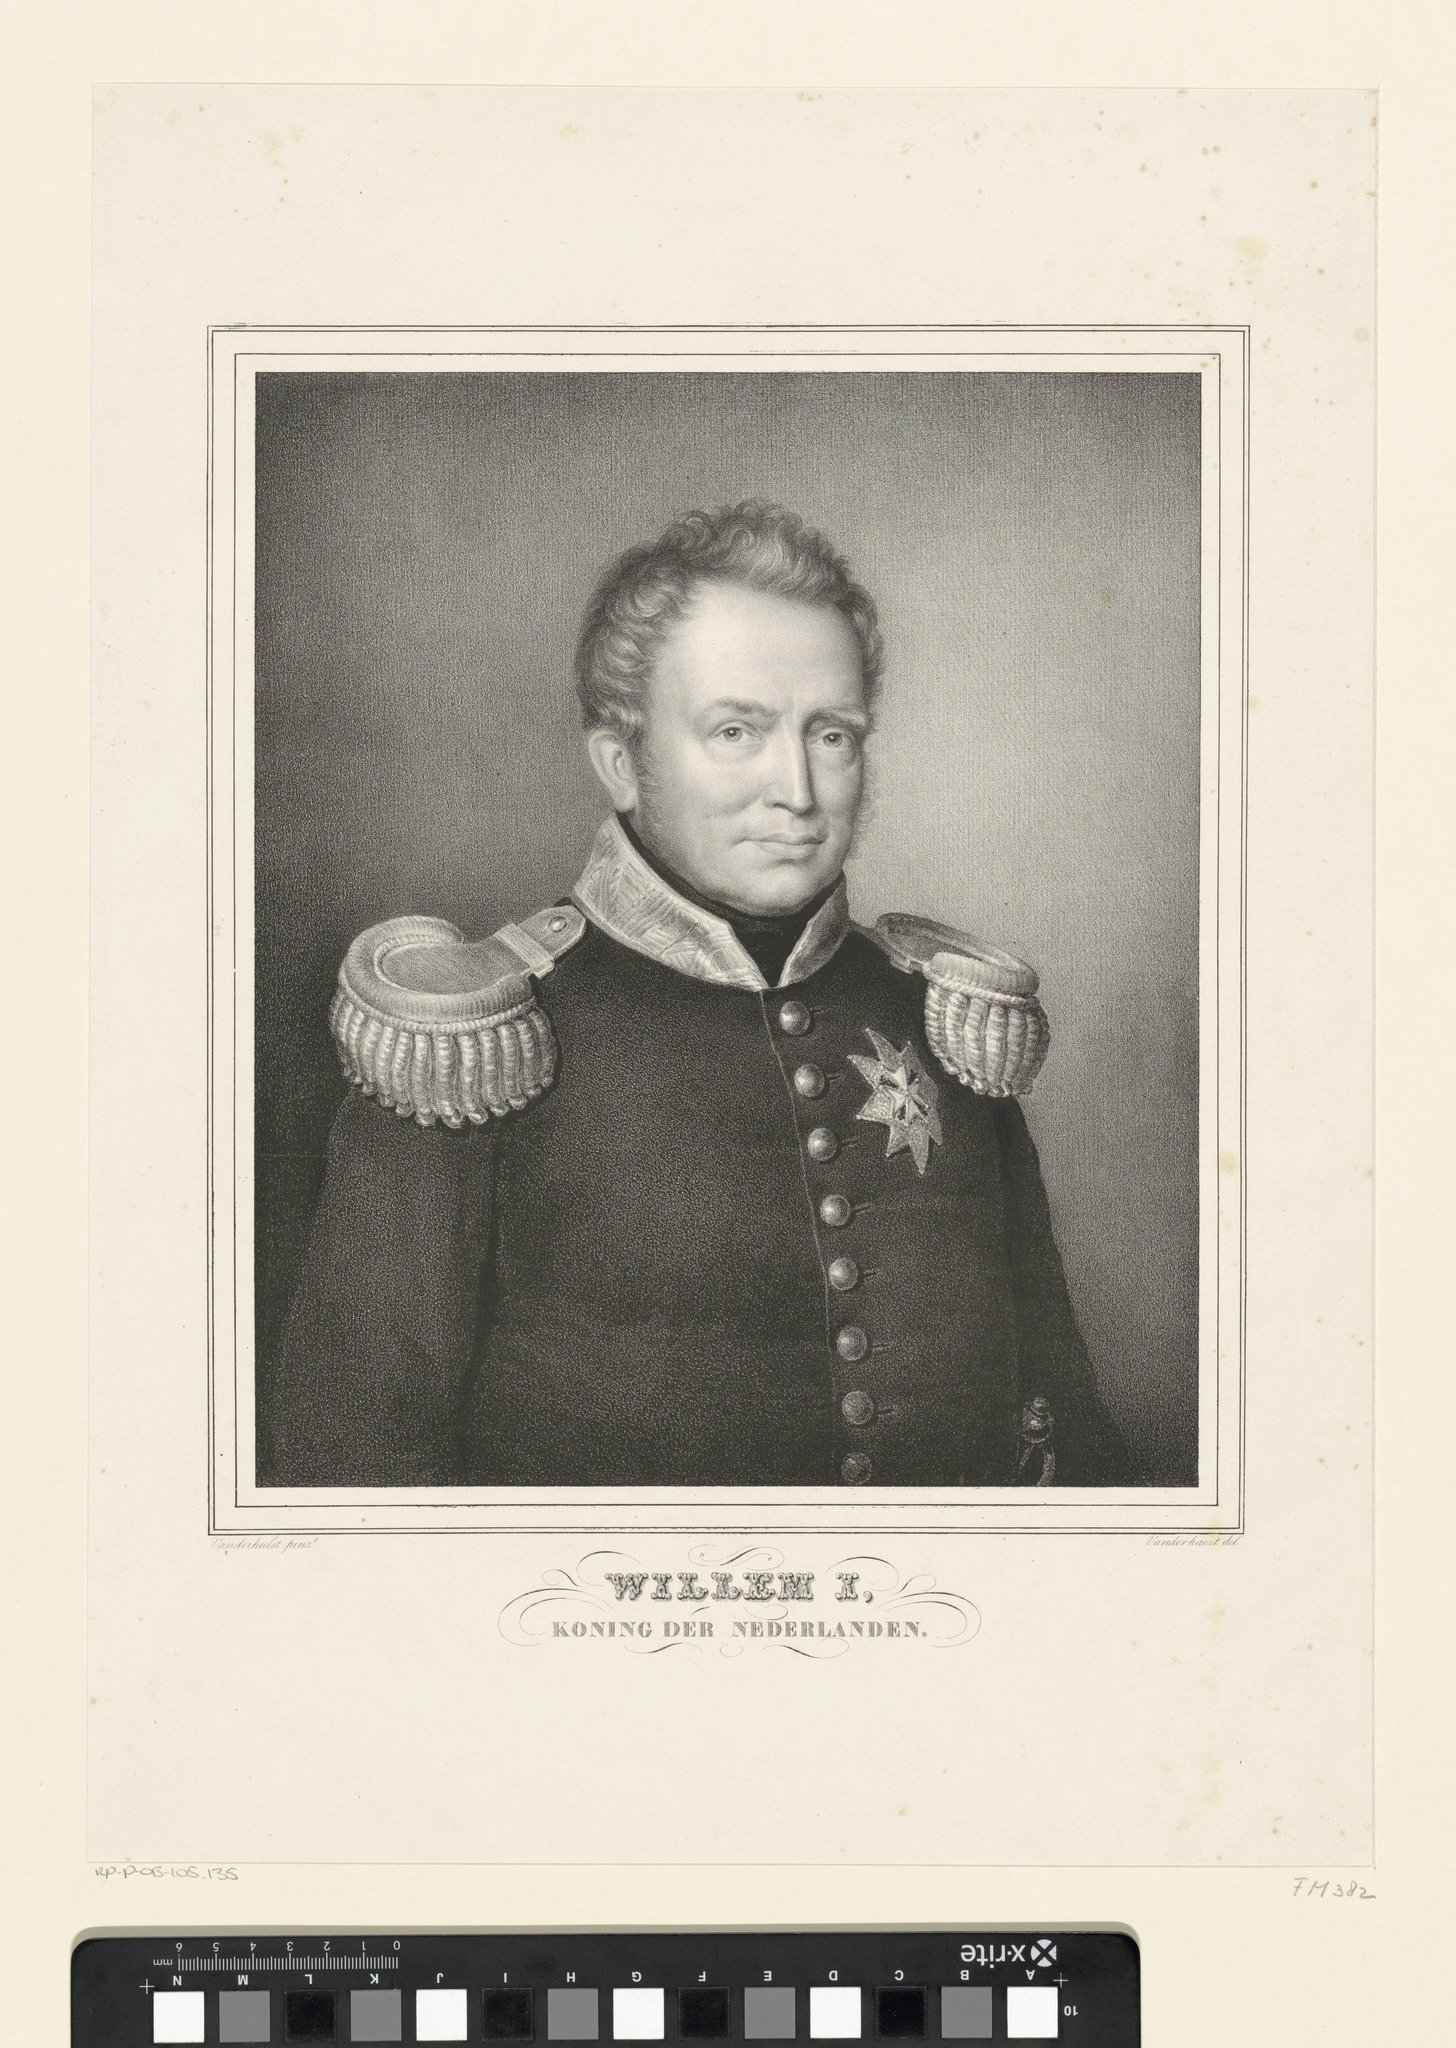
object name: print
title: Portret van Willem I Frederik, koning der Nederlanden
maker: jean-baptiste van der hulst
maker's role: draughtsman, painter, print maker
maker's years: 1790-1862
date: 1831-1832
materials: paper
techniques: lithograph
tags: the hague, berlin, william i of the netherlands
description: De hier vermelde titel verwijst naar de hoogst verkregen titel van de geportretteerde, niet per se naar de titel die de geportretteerde op deze voorstelling draagt.